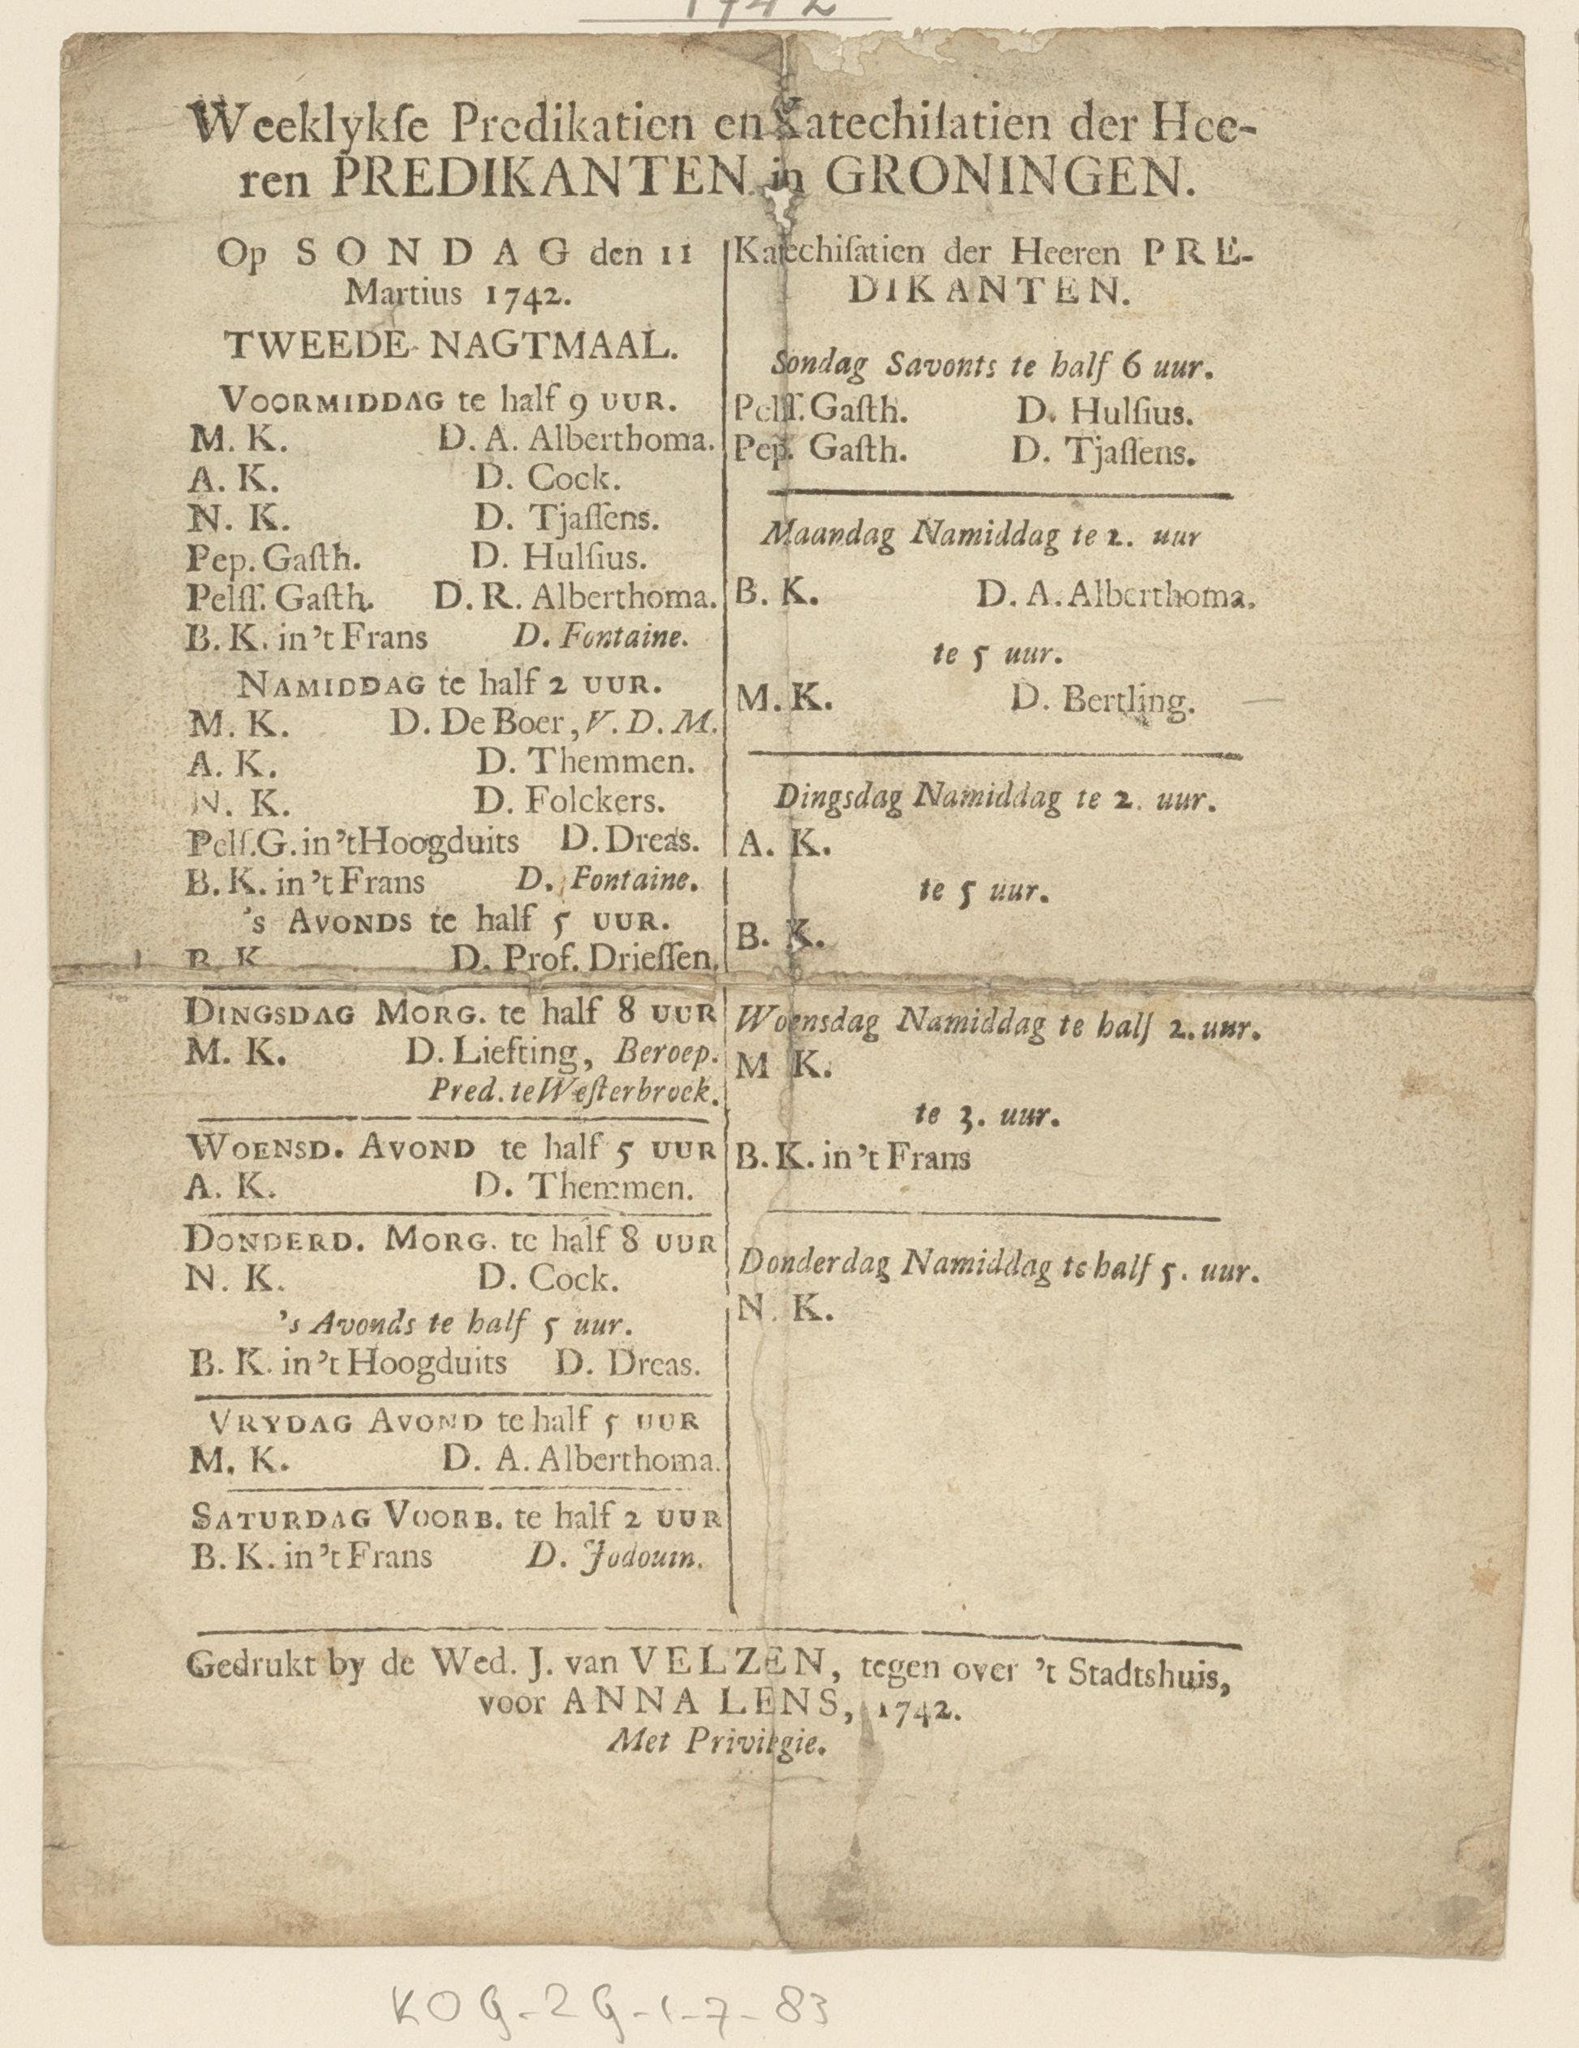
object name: text sheet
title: Aankondigingen van preken in Groningen, 11 maart 1742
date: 1742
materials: paper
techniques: letterpress printing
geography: groningen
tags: preaching (in general)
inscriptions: stamp, collector's mark: Lugt 1641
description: Aankondigingen van de preken in Groningen, 11 maart 1742. Onderwerpsrubrieken binnen de Atlas Zeden en Gewoonten: Godsdienst, Predikbeurtenlijstjes.